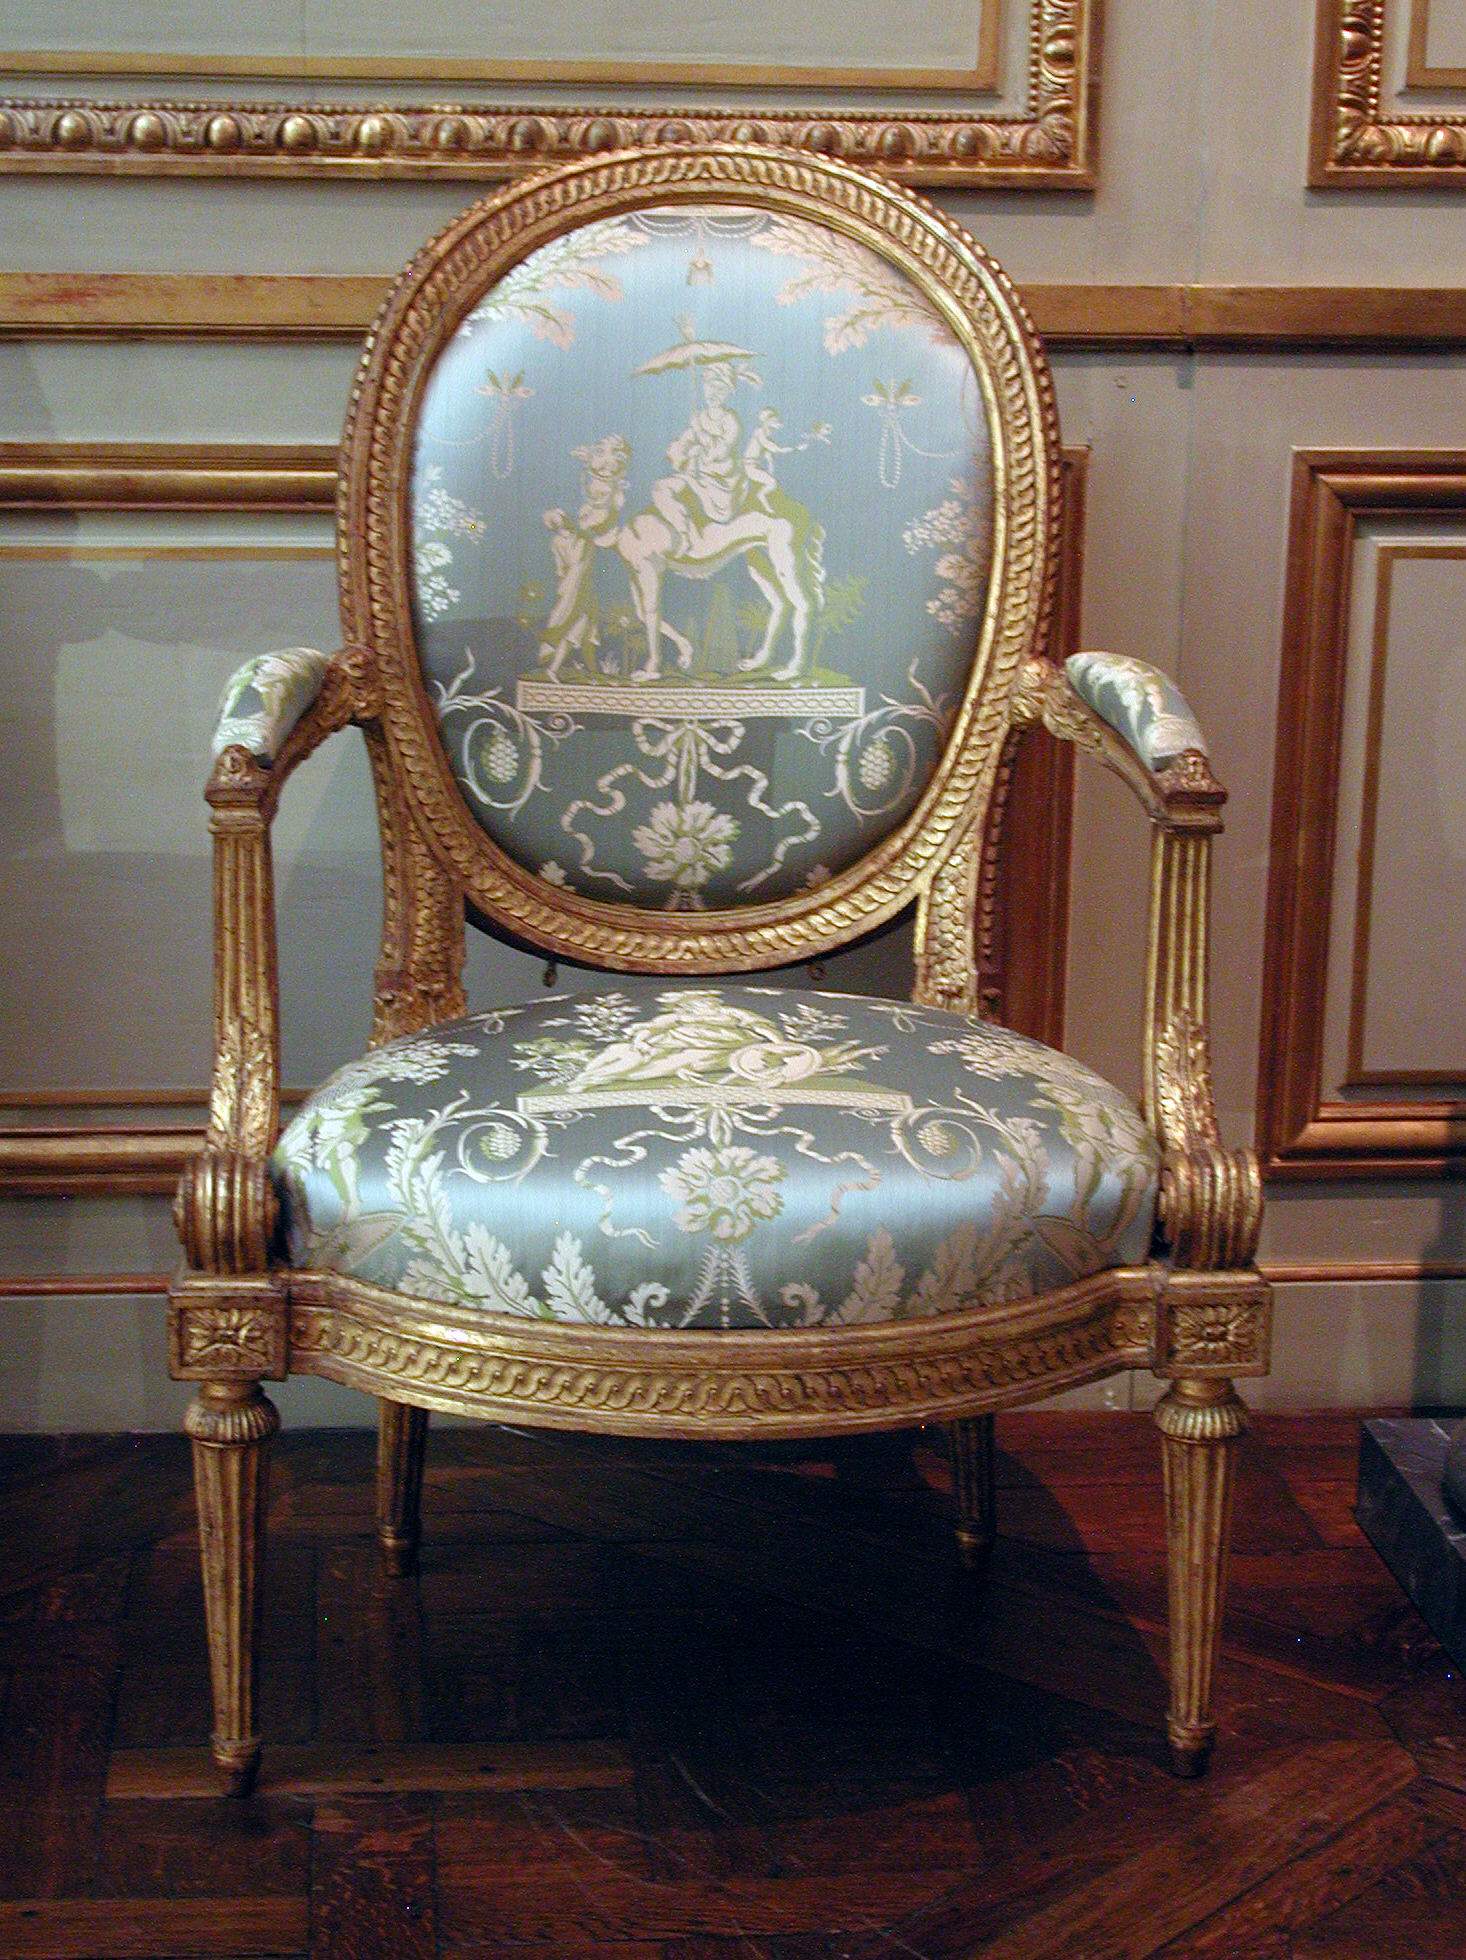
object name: armchair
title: Armchair (one of four) (part of a set)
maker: louis delanois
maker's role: maker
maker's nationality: french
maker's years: 1731-1792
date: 1770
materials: wood, silk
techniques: carving, damask, gilding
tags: human figures,camels